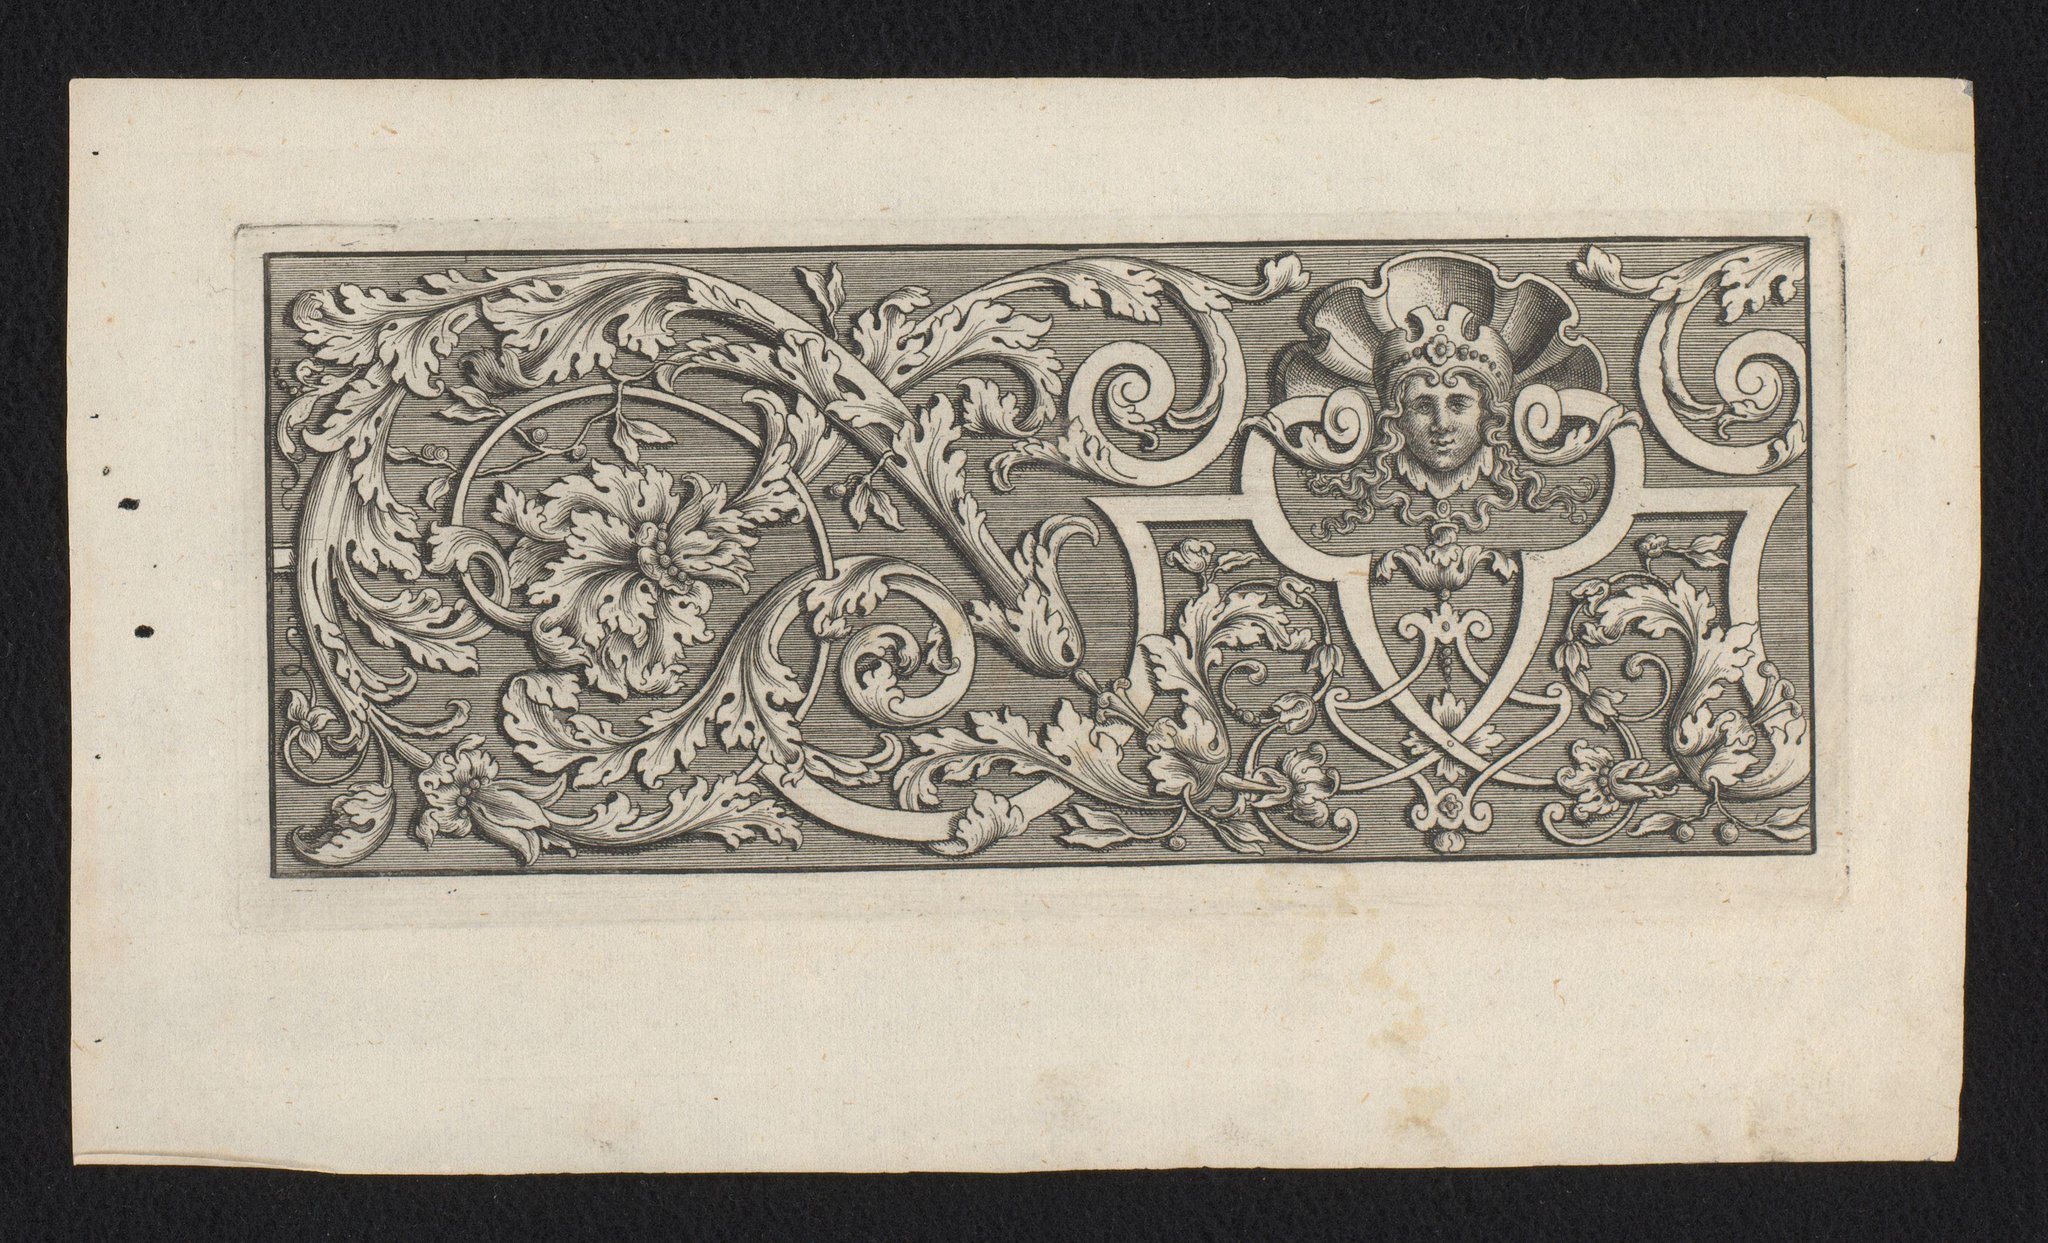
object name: ornament print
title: Neu-inventirtes Laub und Bandl Werk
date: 1705-1710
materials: paper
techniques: engraving, etching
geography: nuremberg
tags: 'laub- und bandelwerk' ~ ornament, mask, mascaron ~ ornament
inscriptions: collector's mark: Lugt 2760, collector's mark: Lugt 2228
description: Vlechtwerk met bladmotieven. Rechts een vrouwengezicht in een schelpvorm